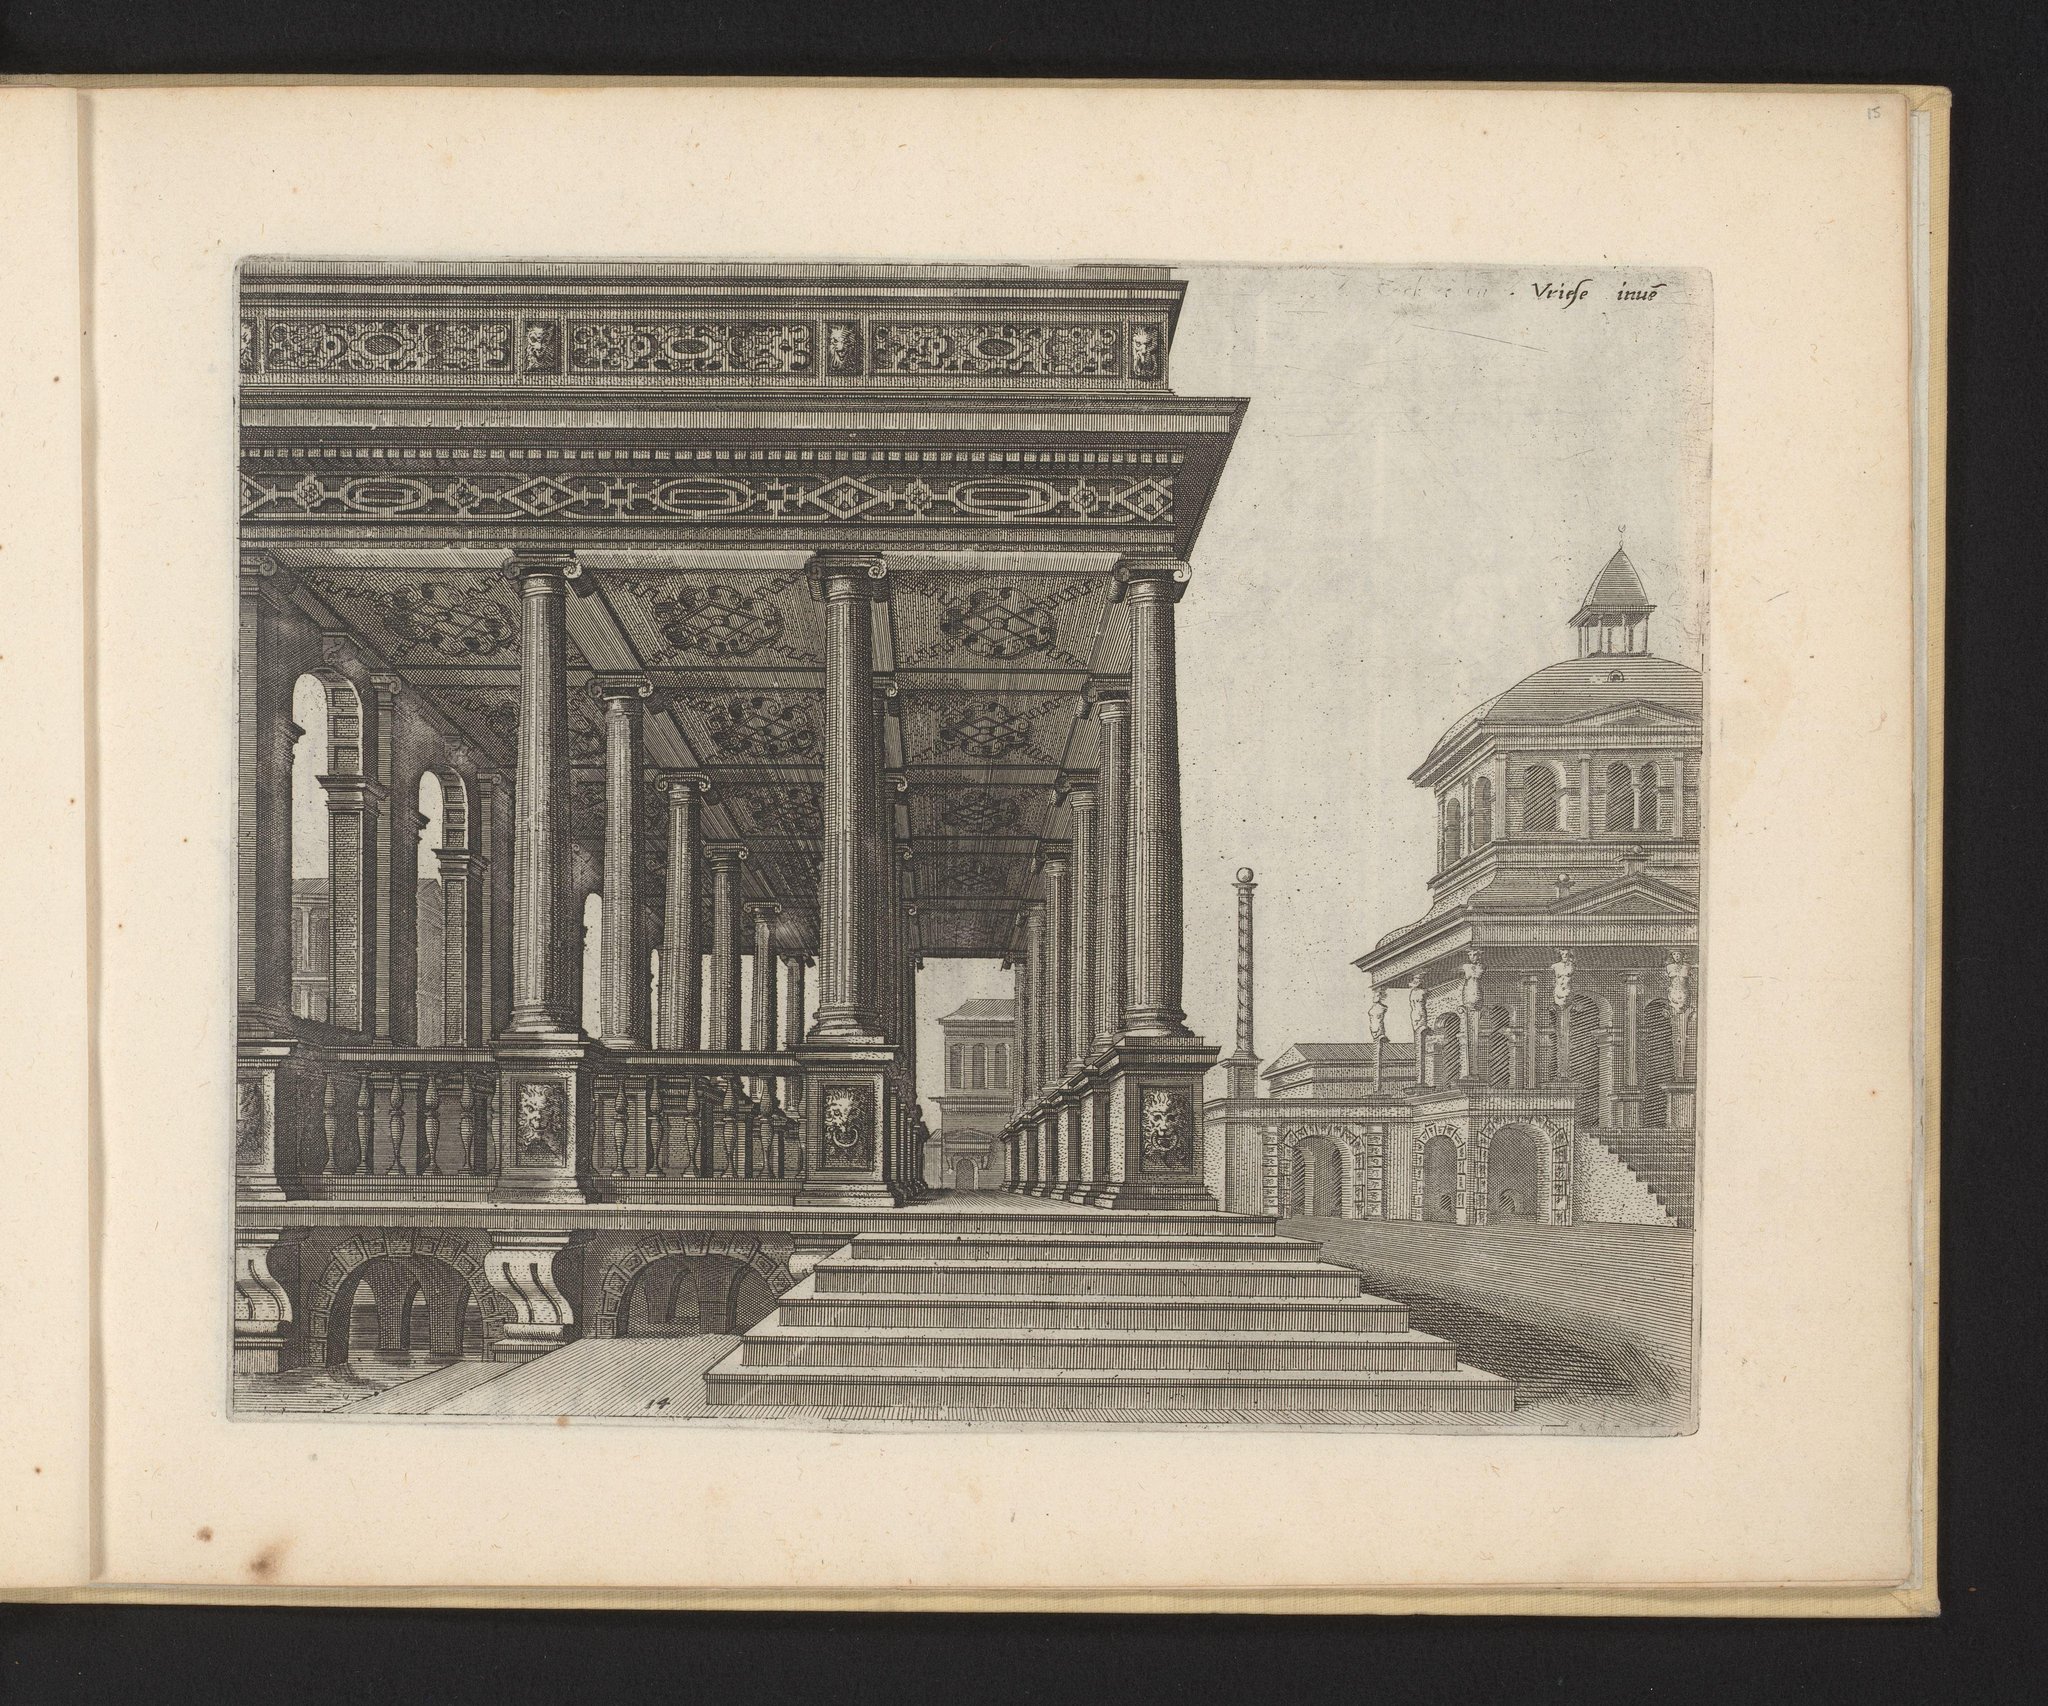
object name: ornament print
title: Variae architecturae formae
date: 1601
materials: paper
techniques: engraving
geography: antwerp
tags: gallery (spacious corridor)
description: Links een hal ondersteund door zuilen van de Ionische orde. Het fries is gedecoreerd met beslagwerk, de attiek met rolwerk tussen mascarons. Onder de hal stroomt water. De prent maakt deel uit van een album.